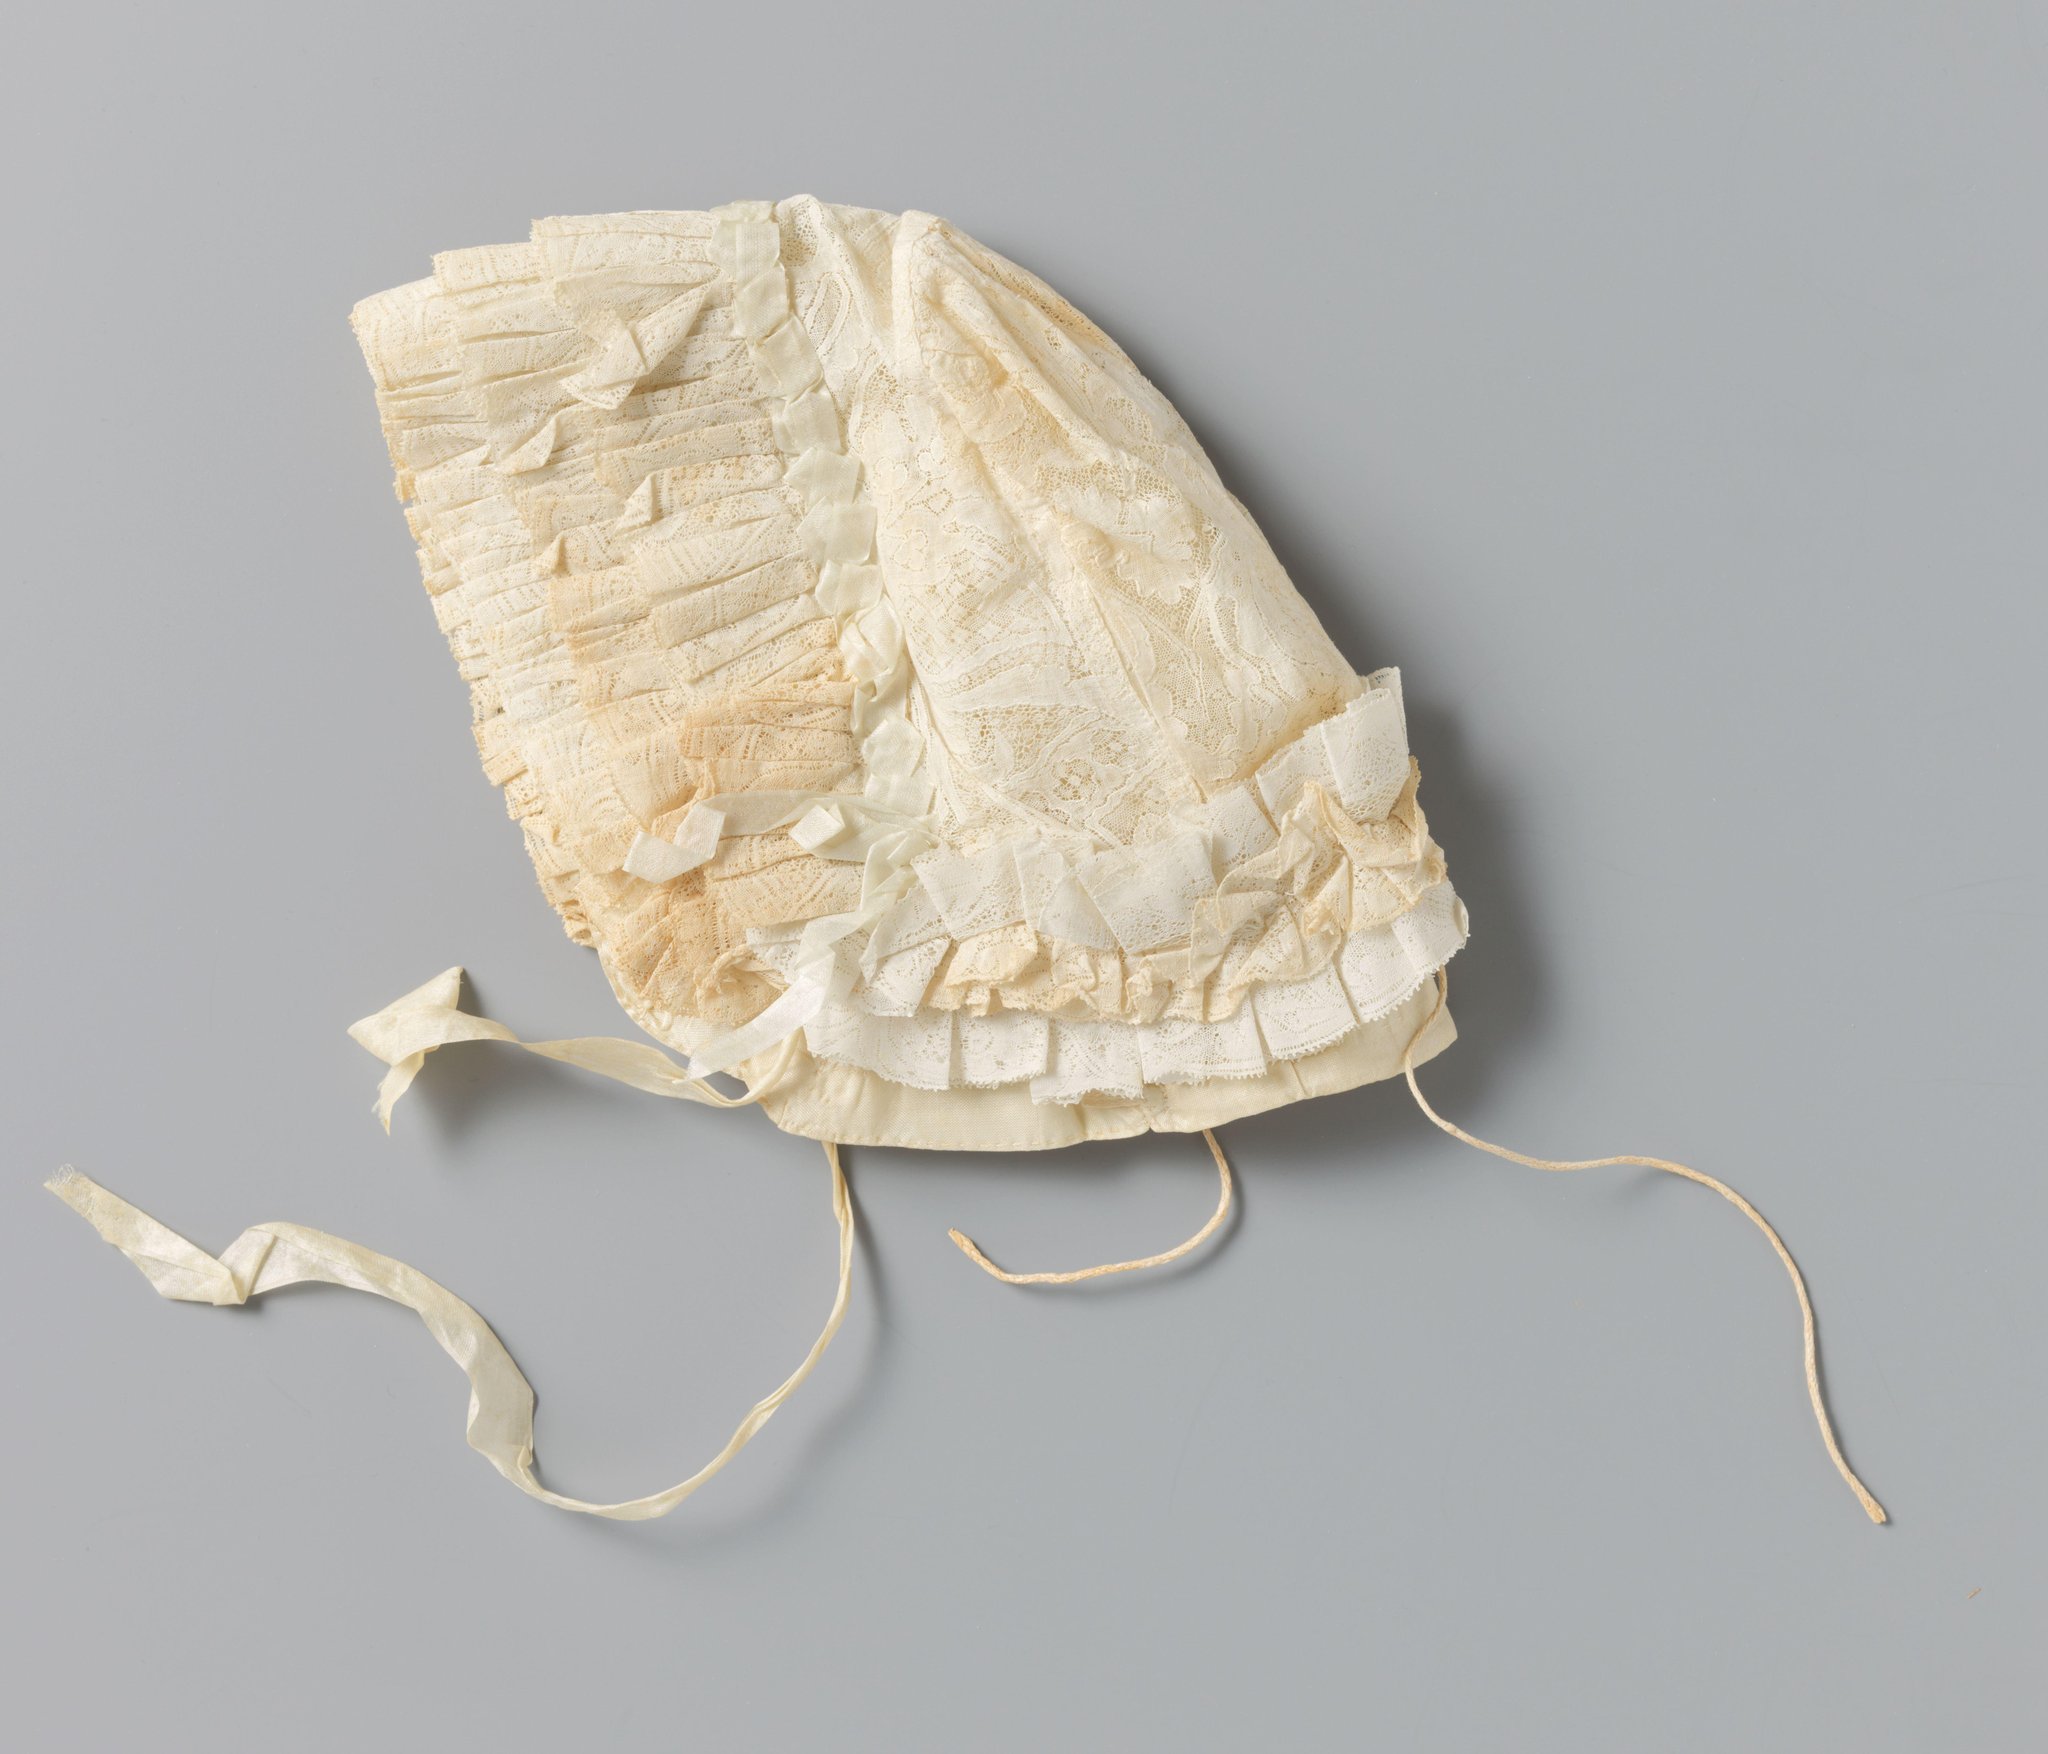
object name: childrenswear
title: Kindermuts van Mechelse kant, rondom versierd met meerdere ruches en een ruche van lichtblauwe zijde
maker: Anonymous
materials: silk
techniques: lace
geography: europe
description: Een zijden mutsvoering behoorende bij een muts van kloskant (Mâlines met geplooiden rand.